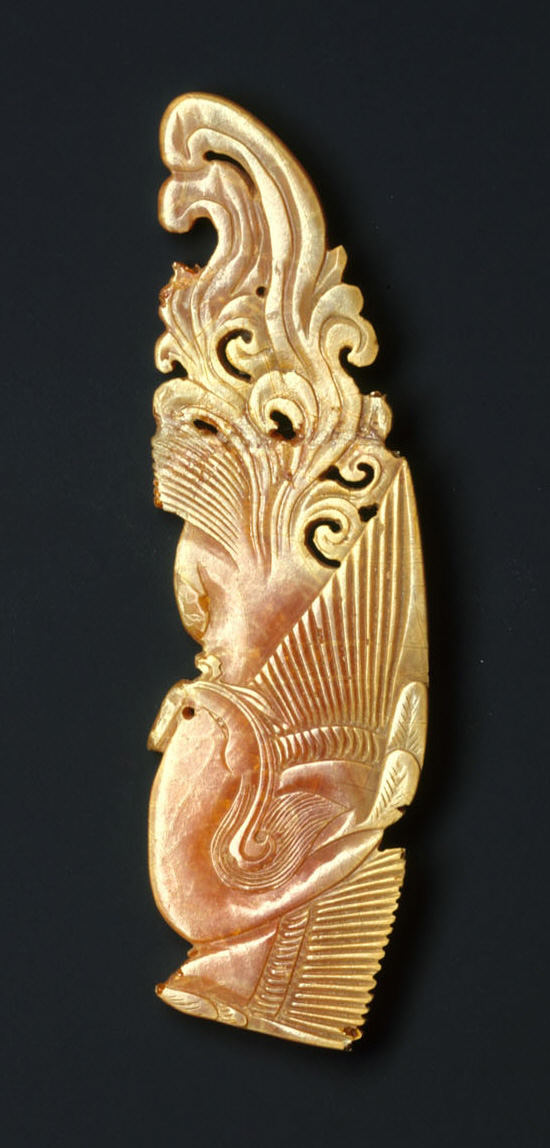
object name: plaque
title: Ornamental plaque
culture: chinese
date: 701-800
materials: amber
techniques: incising